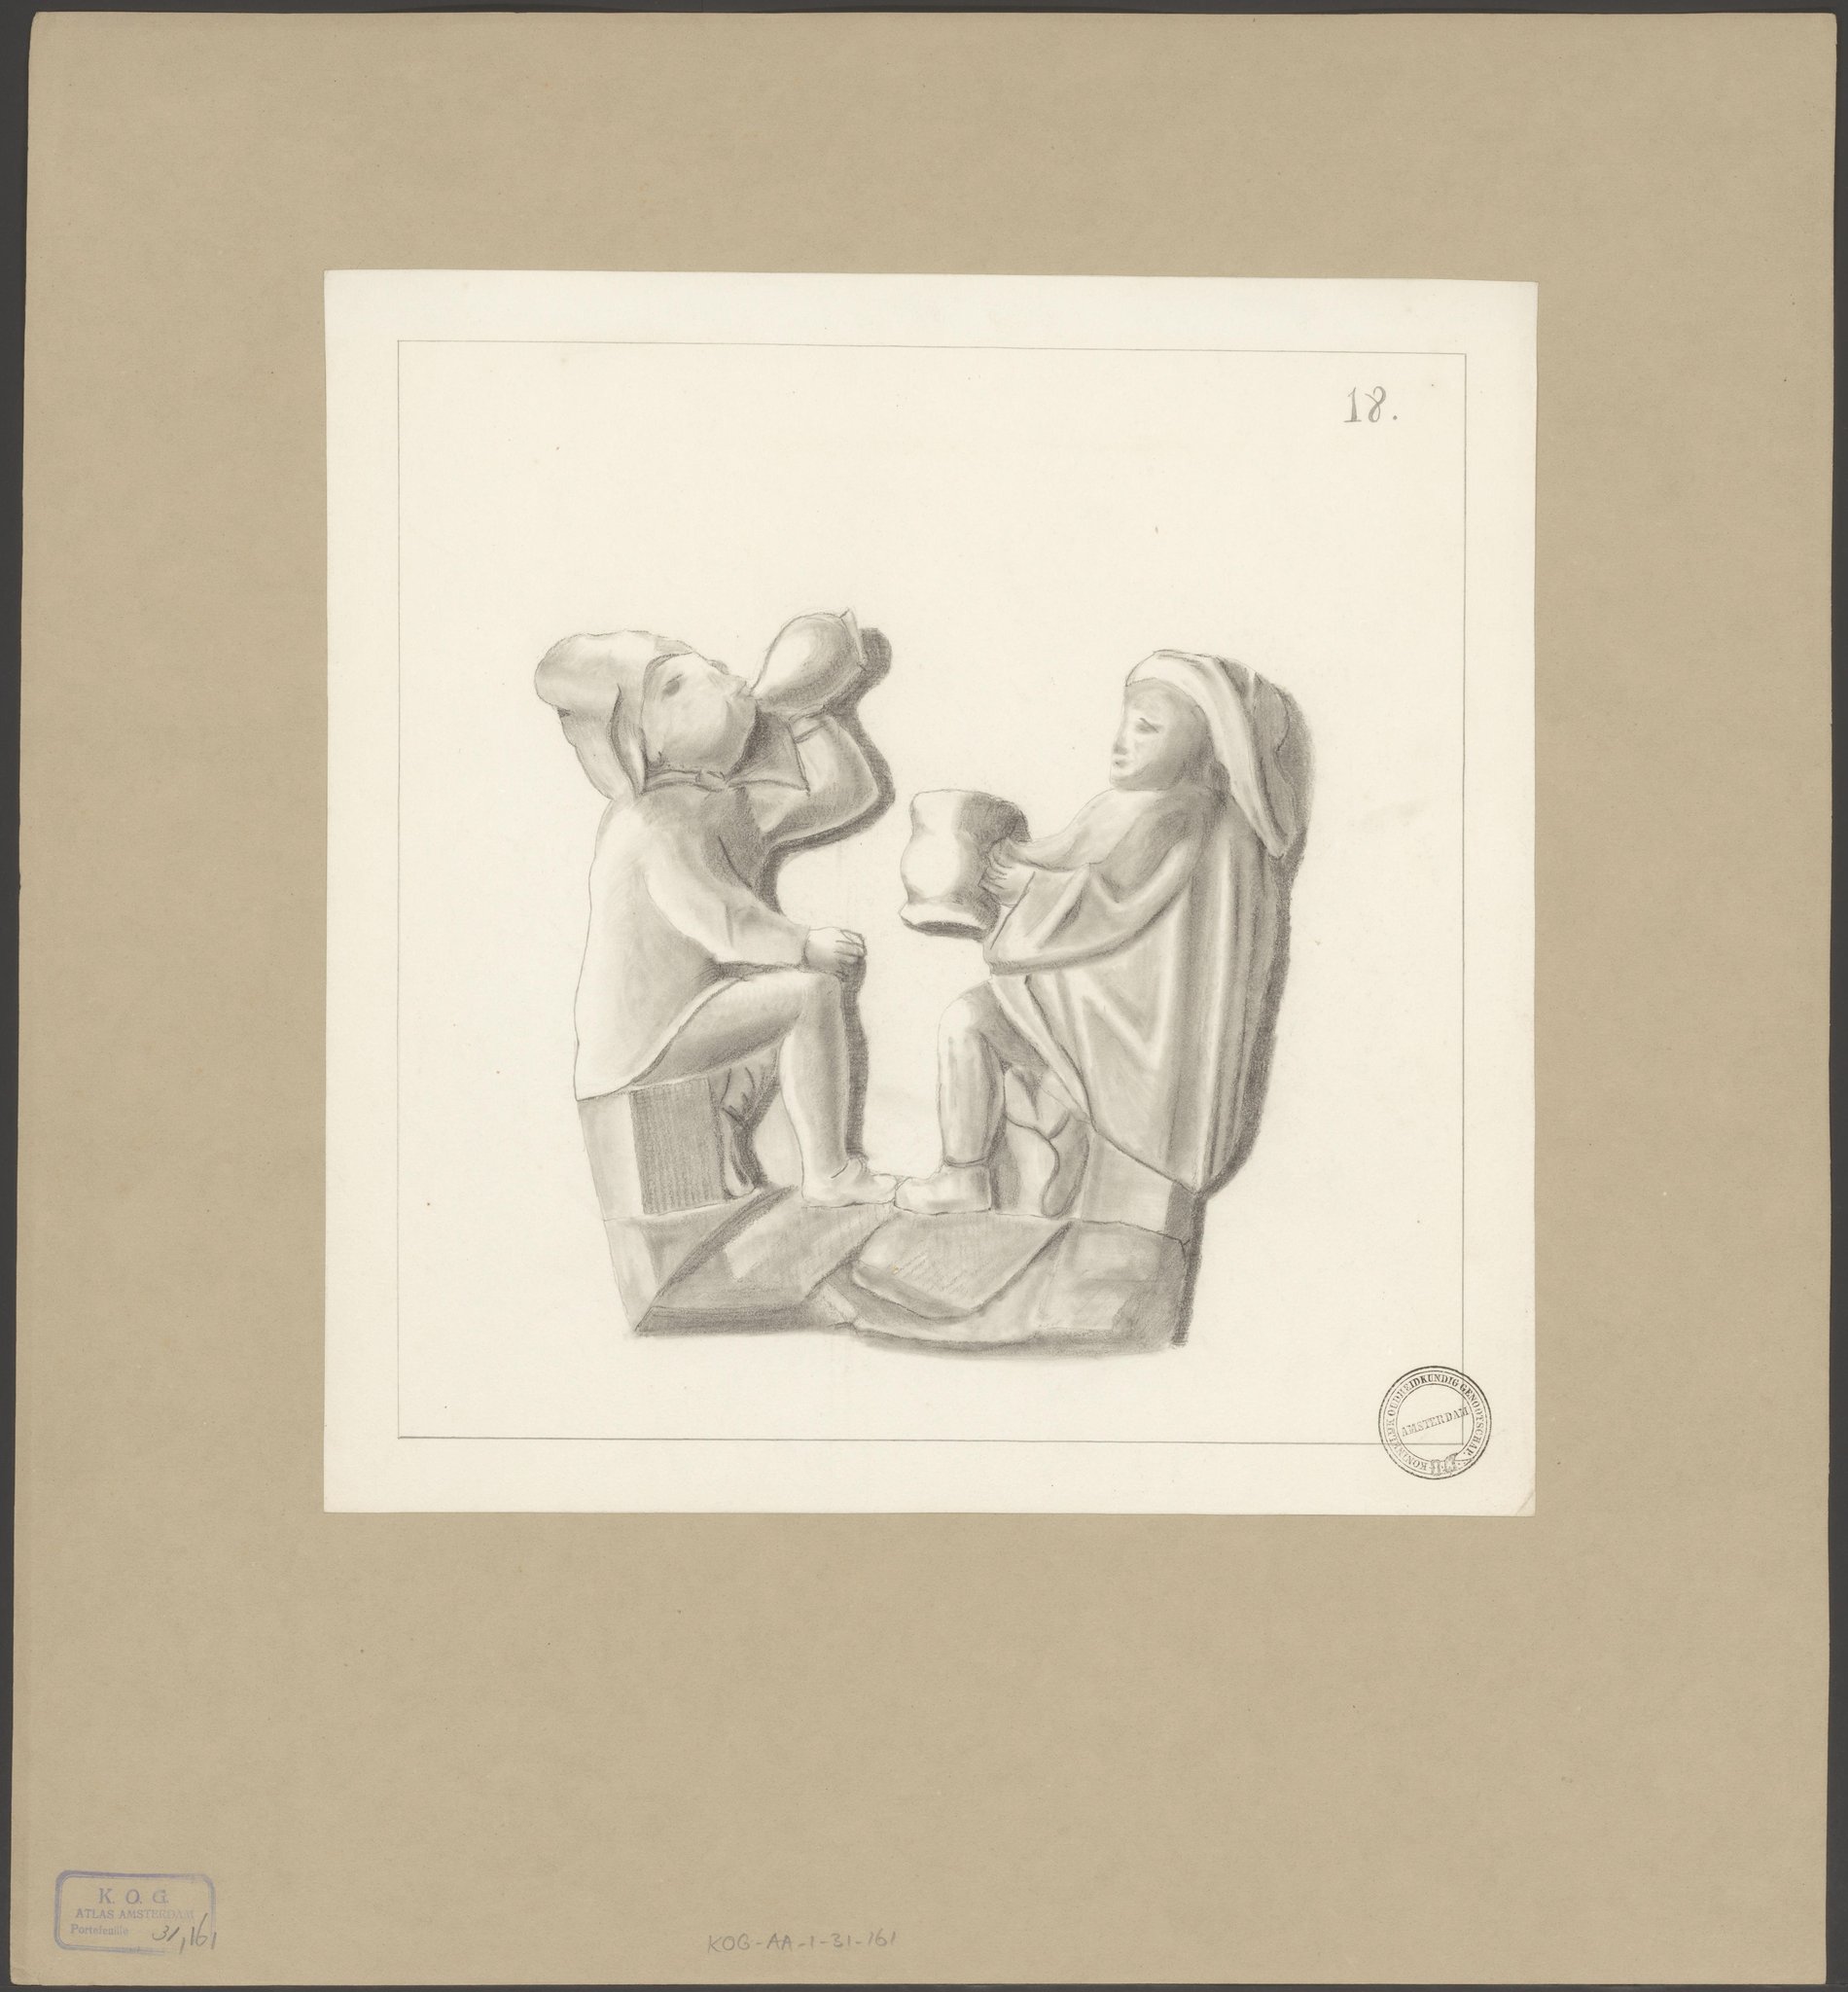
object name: print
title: Misericorde met twee drinkende figuren in de Oude Kerk te Amsterdam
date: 1880-1929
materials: paper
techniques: lithograph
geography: amsterdam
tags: misericords, drinking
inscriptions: collector's mark: ‘31,161’ Lugt 1641b, collector's mark: ‘Koninklijk Oudheidkundig Genootschap / Amsterdam’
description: Rechtsboven genummerd: 18. Onderwerpsrubriek binnen de Atlas Amsterdam: Kerkwezen: Hervormde Gemeente: Oude Kerk, koorgestoelte.